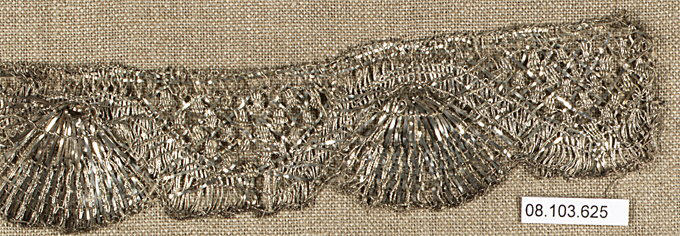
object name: piece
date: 1701-1800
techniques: lace